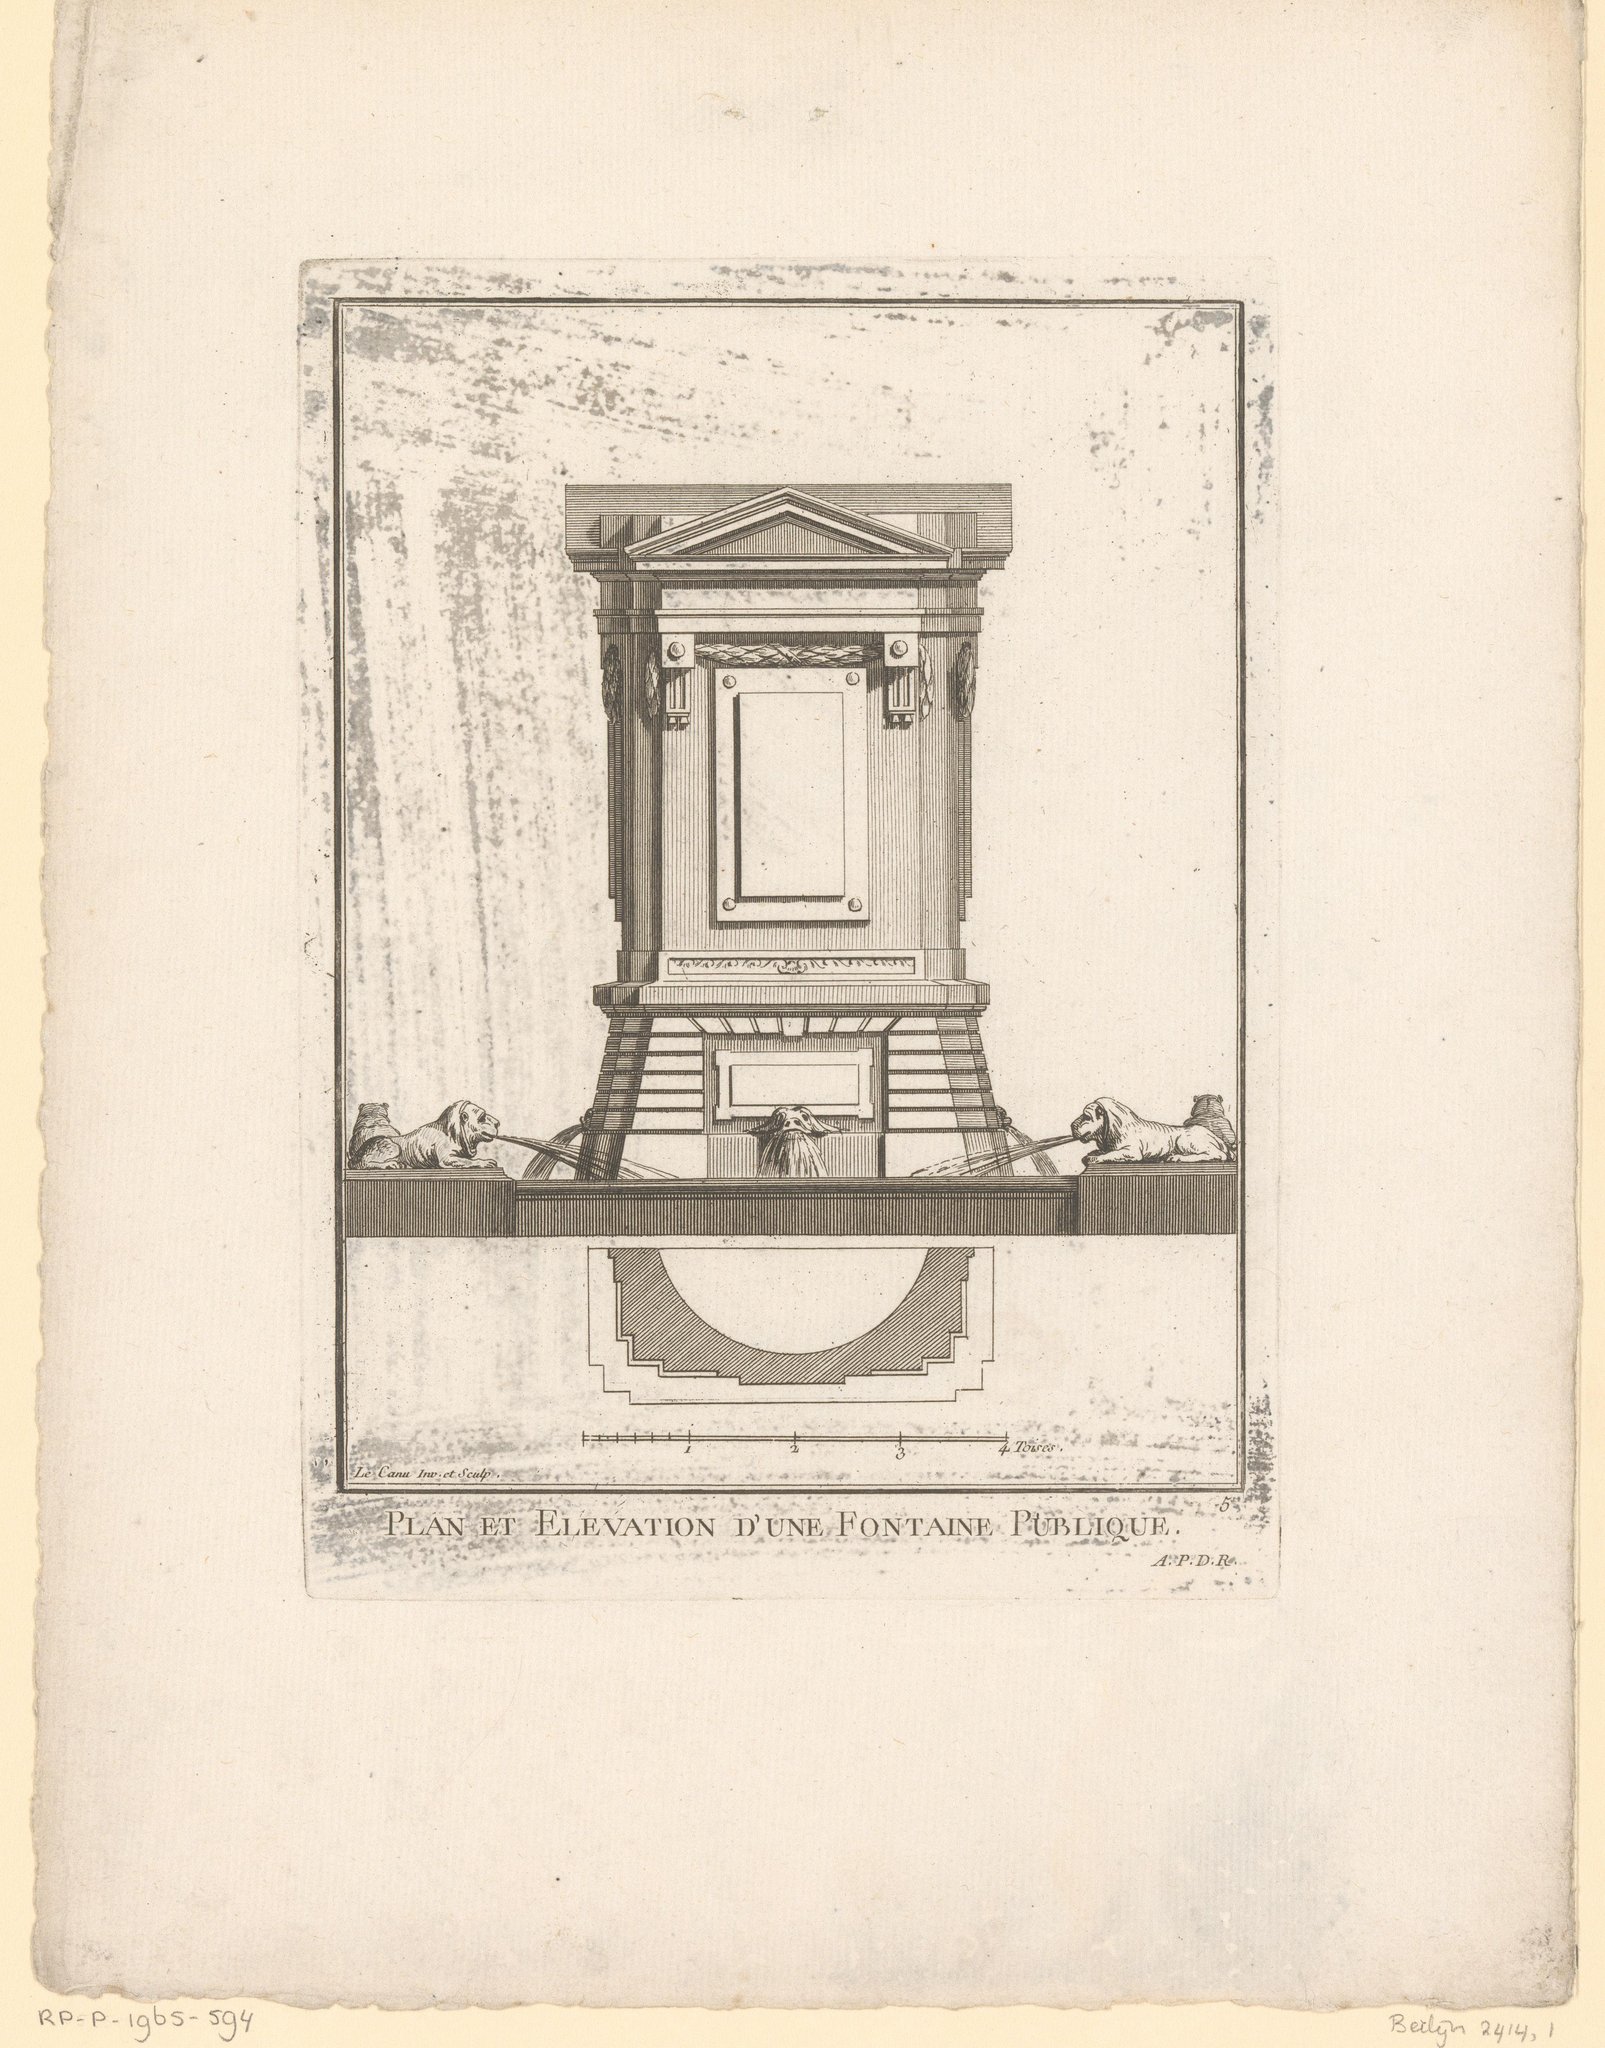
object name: print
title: Fontein met leeuwen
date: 1778-1782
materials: paper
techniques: etching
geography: paris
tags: ornamental fountain, beasts of prey, predatory animals: lion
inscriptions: collector's mark: Lugt 2760, collector's mark: Lugt 2228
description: Vooraanzicht en plattegrond van een geornamenteerde fontein met leeuwen. De fontein is in de vorm van een façade van een gebouw met een rechthoekig tablet en een driehoekig fronton.